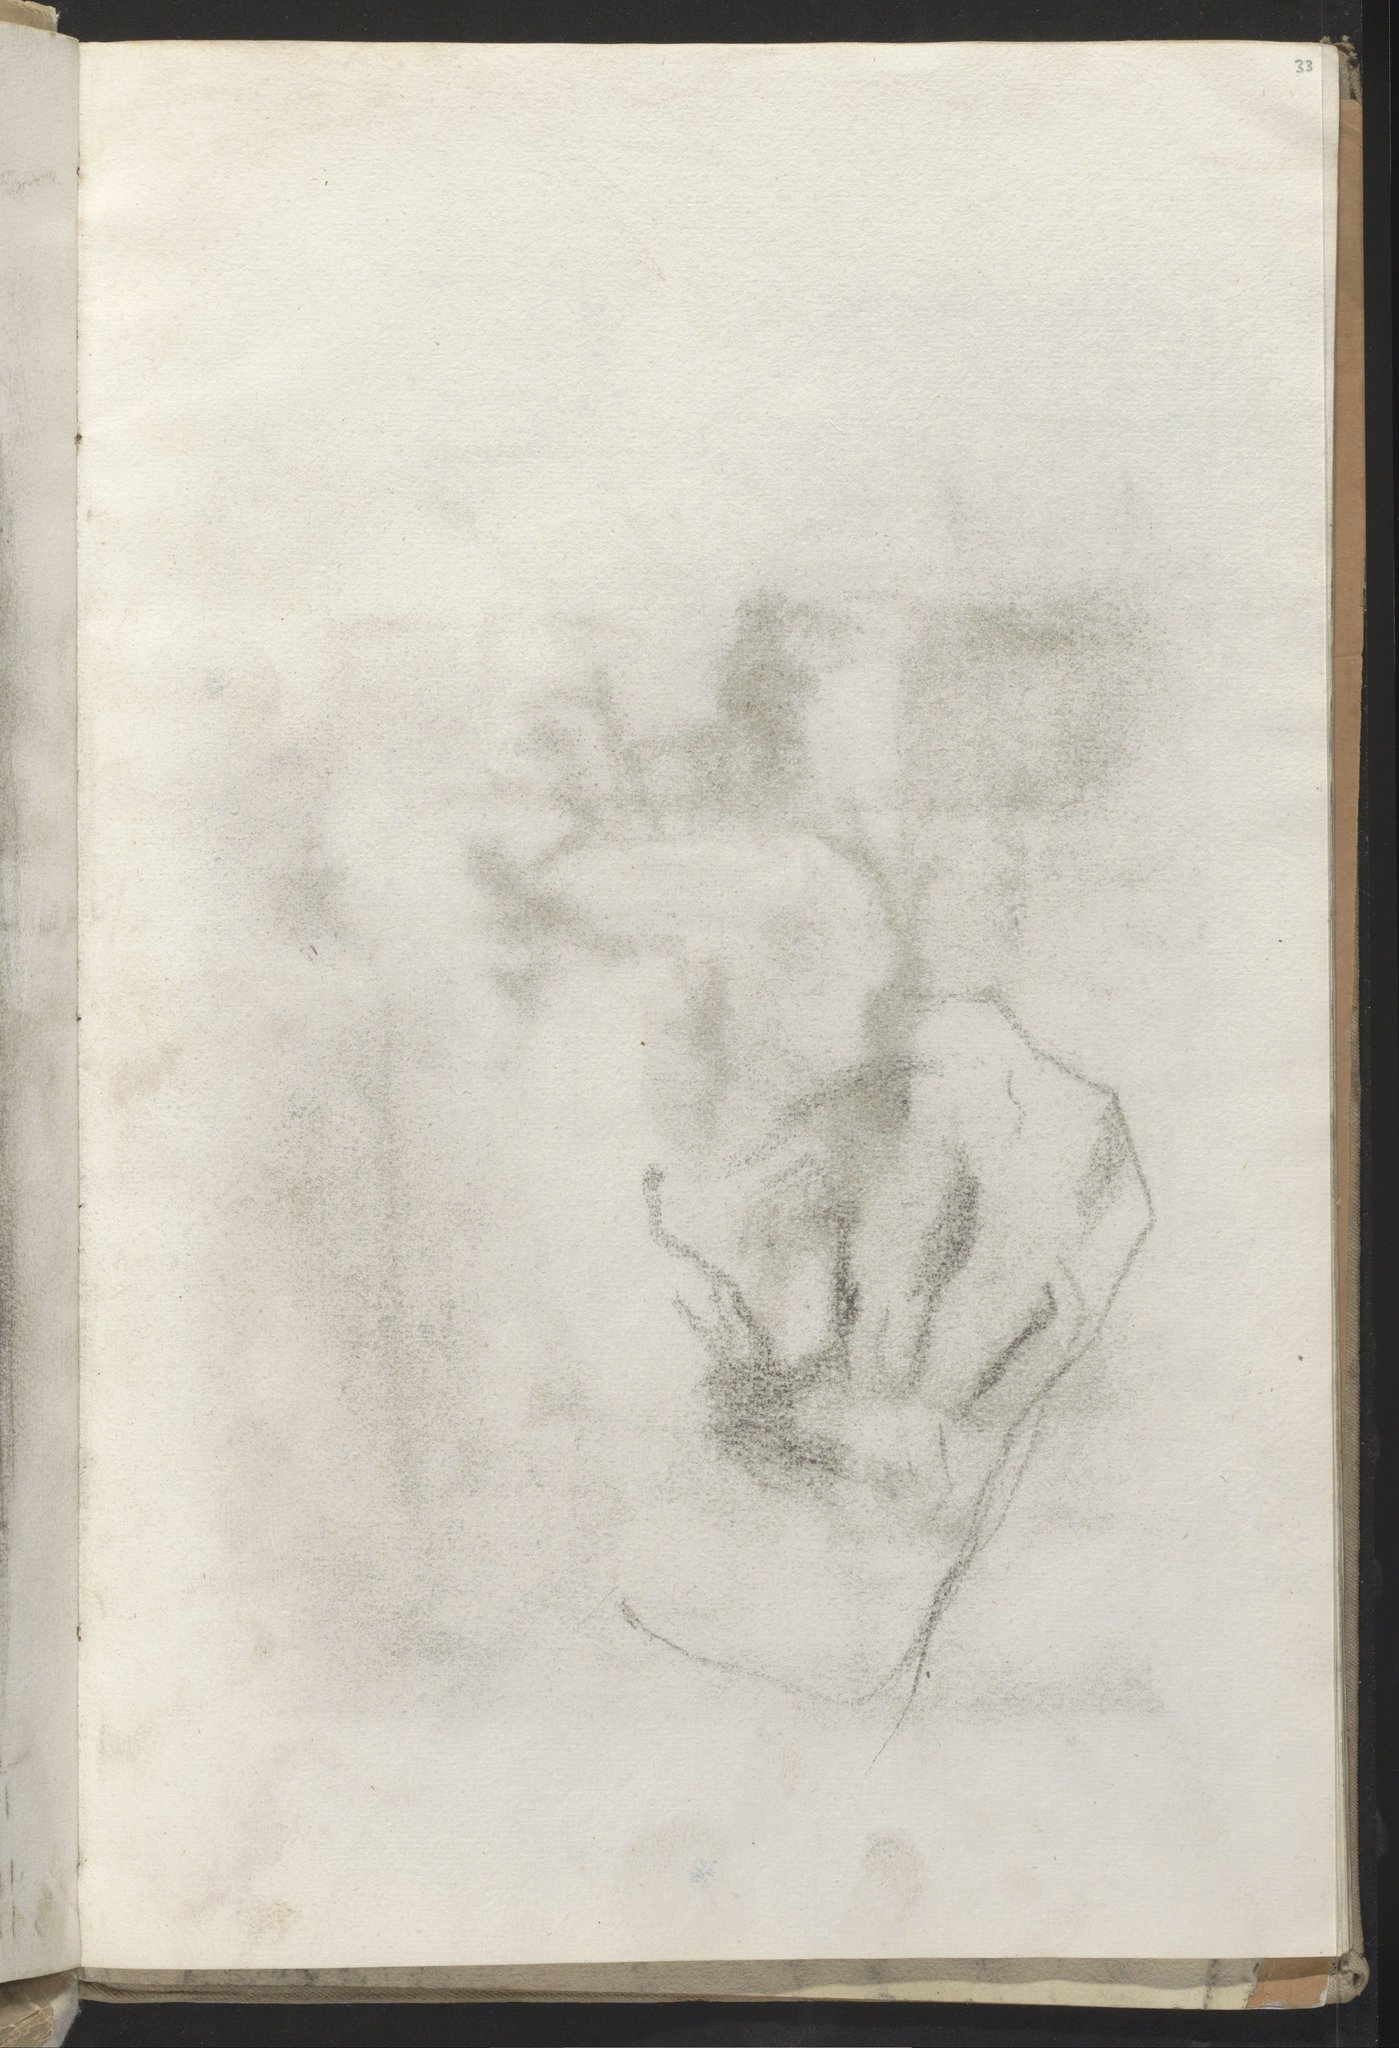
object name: sketchbook leaf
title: Jurk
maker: albert neuhuys (1844-1914)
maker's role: draughtsman, painter, print maker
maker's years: 1844-1914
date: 1854-1914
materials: charcoal, paper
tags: dress, gown (+ women's clothes)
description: Blad 33 recto uit een schetsboek met 53 bladen.